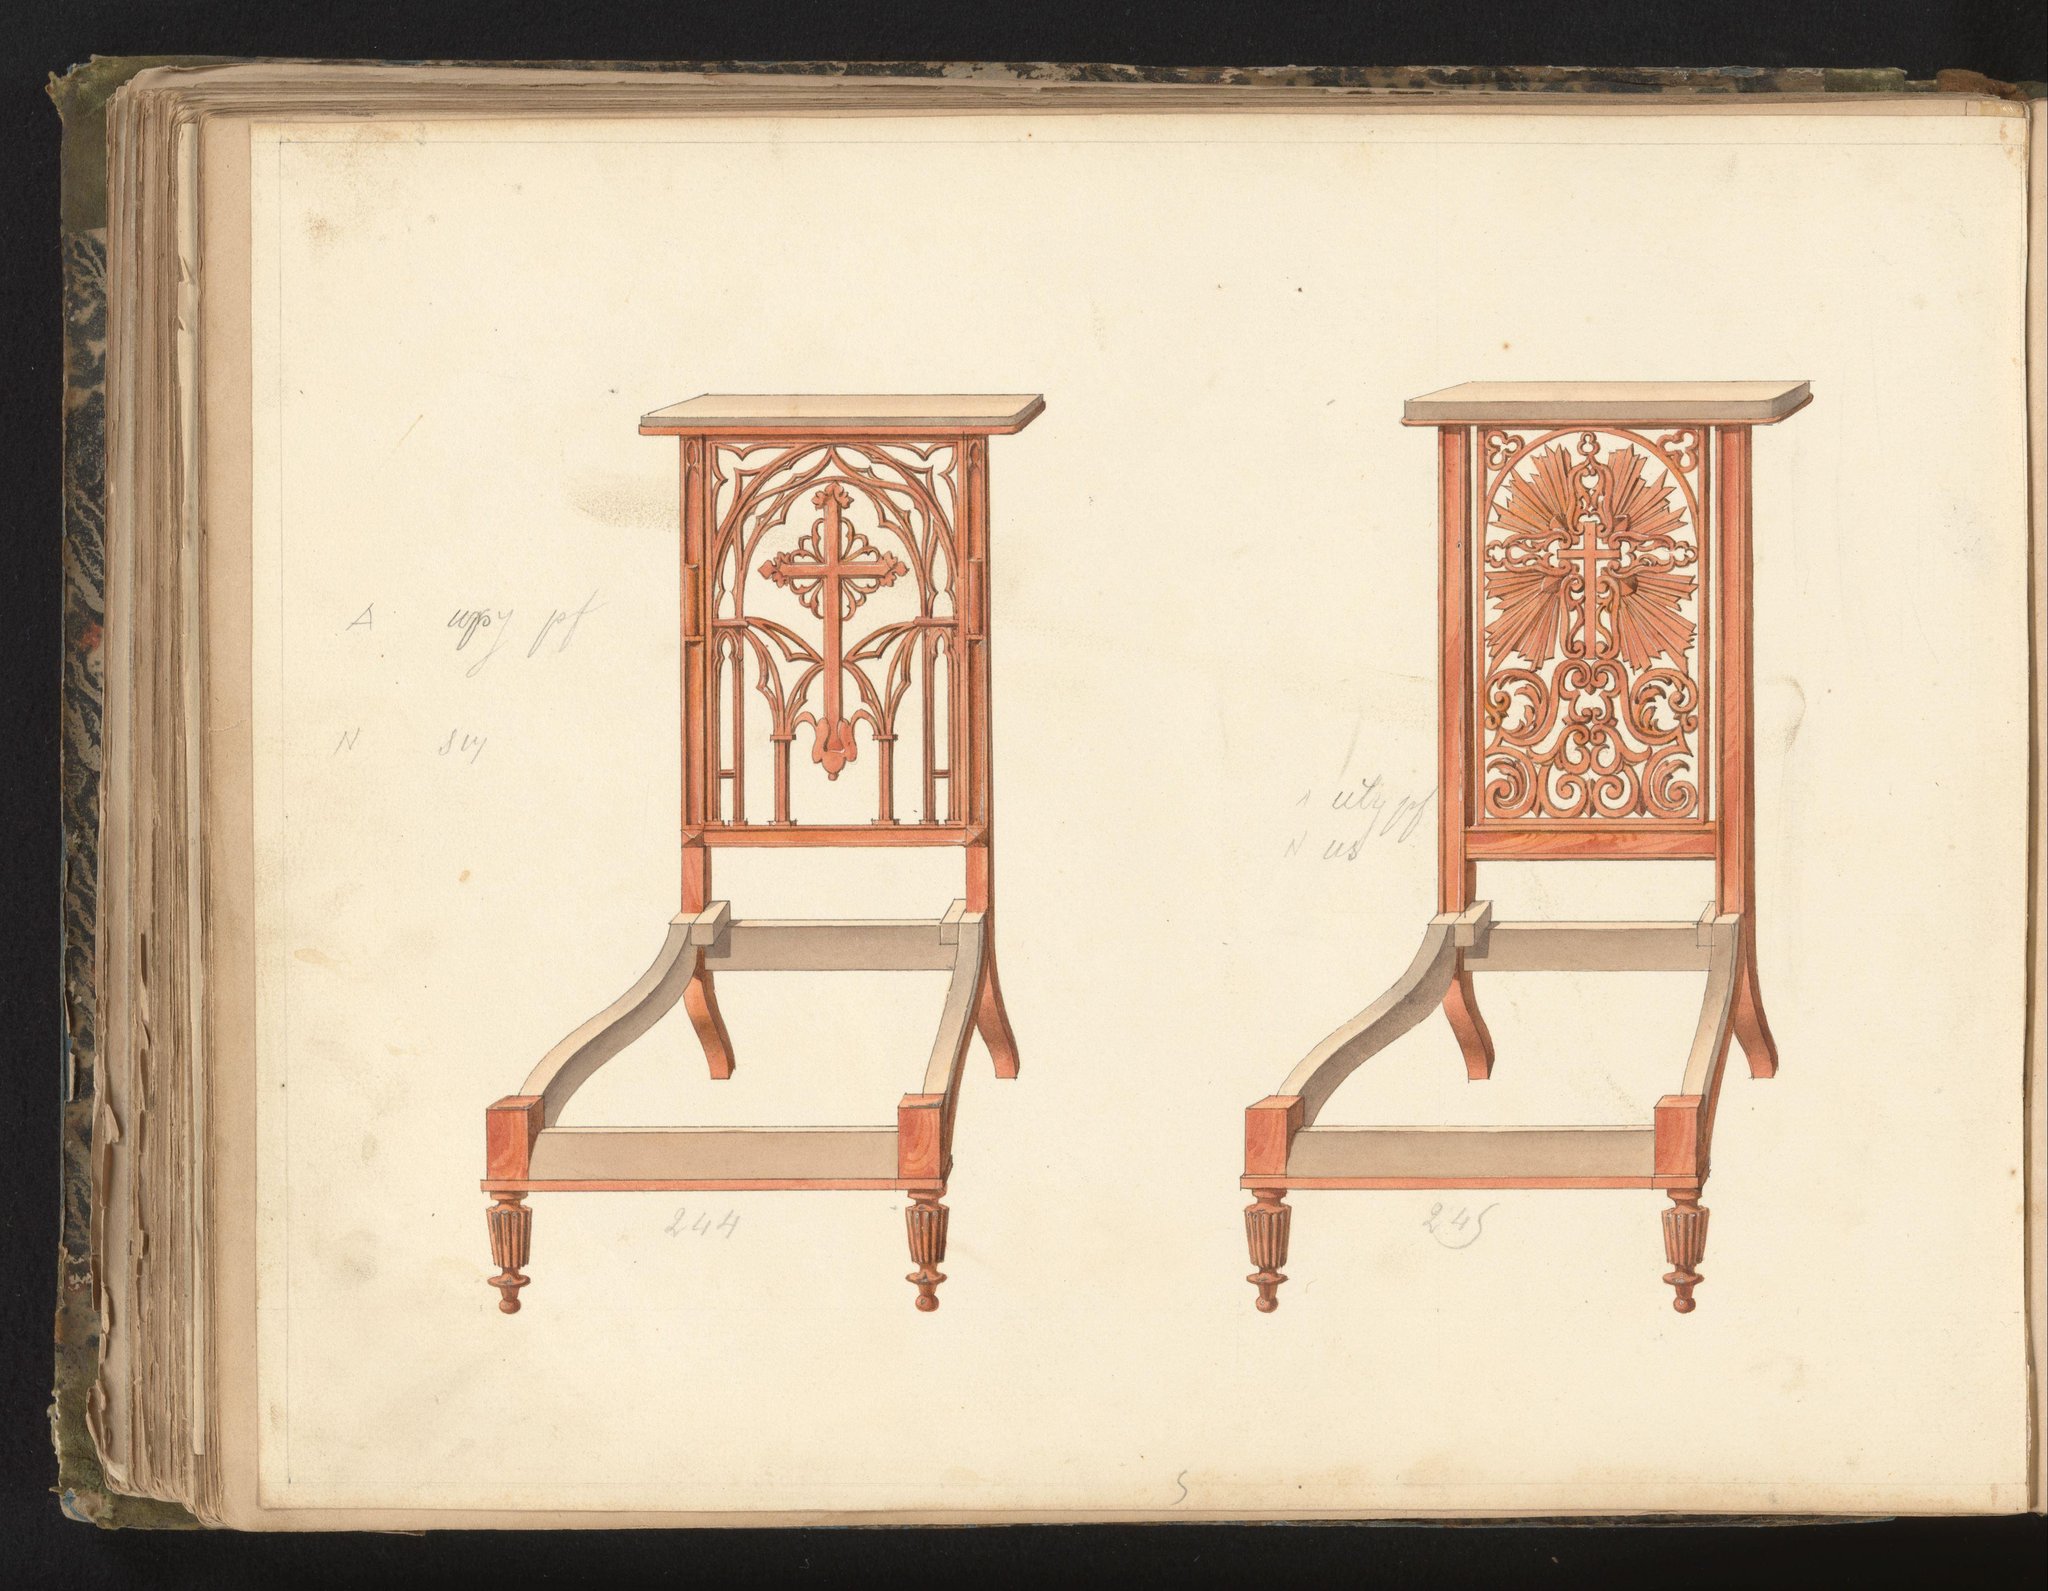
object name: drawing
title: Twee ontwerpen voor prie-dieu’s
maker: Anonymous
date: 1825-1839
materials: ink, paper, pencil, watercolor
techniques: brush, pen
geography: paris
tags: kneeling-chair, furniture for special use (+ wood and other phytogenic material)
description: Twee ontwerpen voor prie-dieu’s (bidstoelen), zonder bekleding, met rijk versierd snijwerk. Het blad op de achterzijde genummerd: 50, het tegenoverliggende blad met informatie (ontbreekt hier) over de afgebeelde meubelen genummerd: 50 bis. Onderdeel van een album met 80 bladen met tekeningen en een prent van gefineerde en gelakte meubelen, alsmede zitmeubelen.